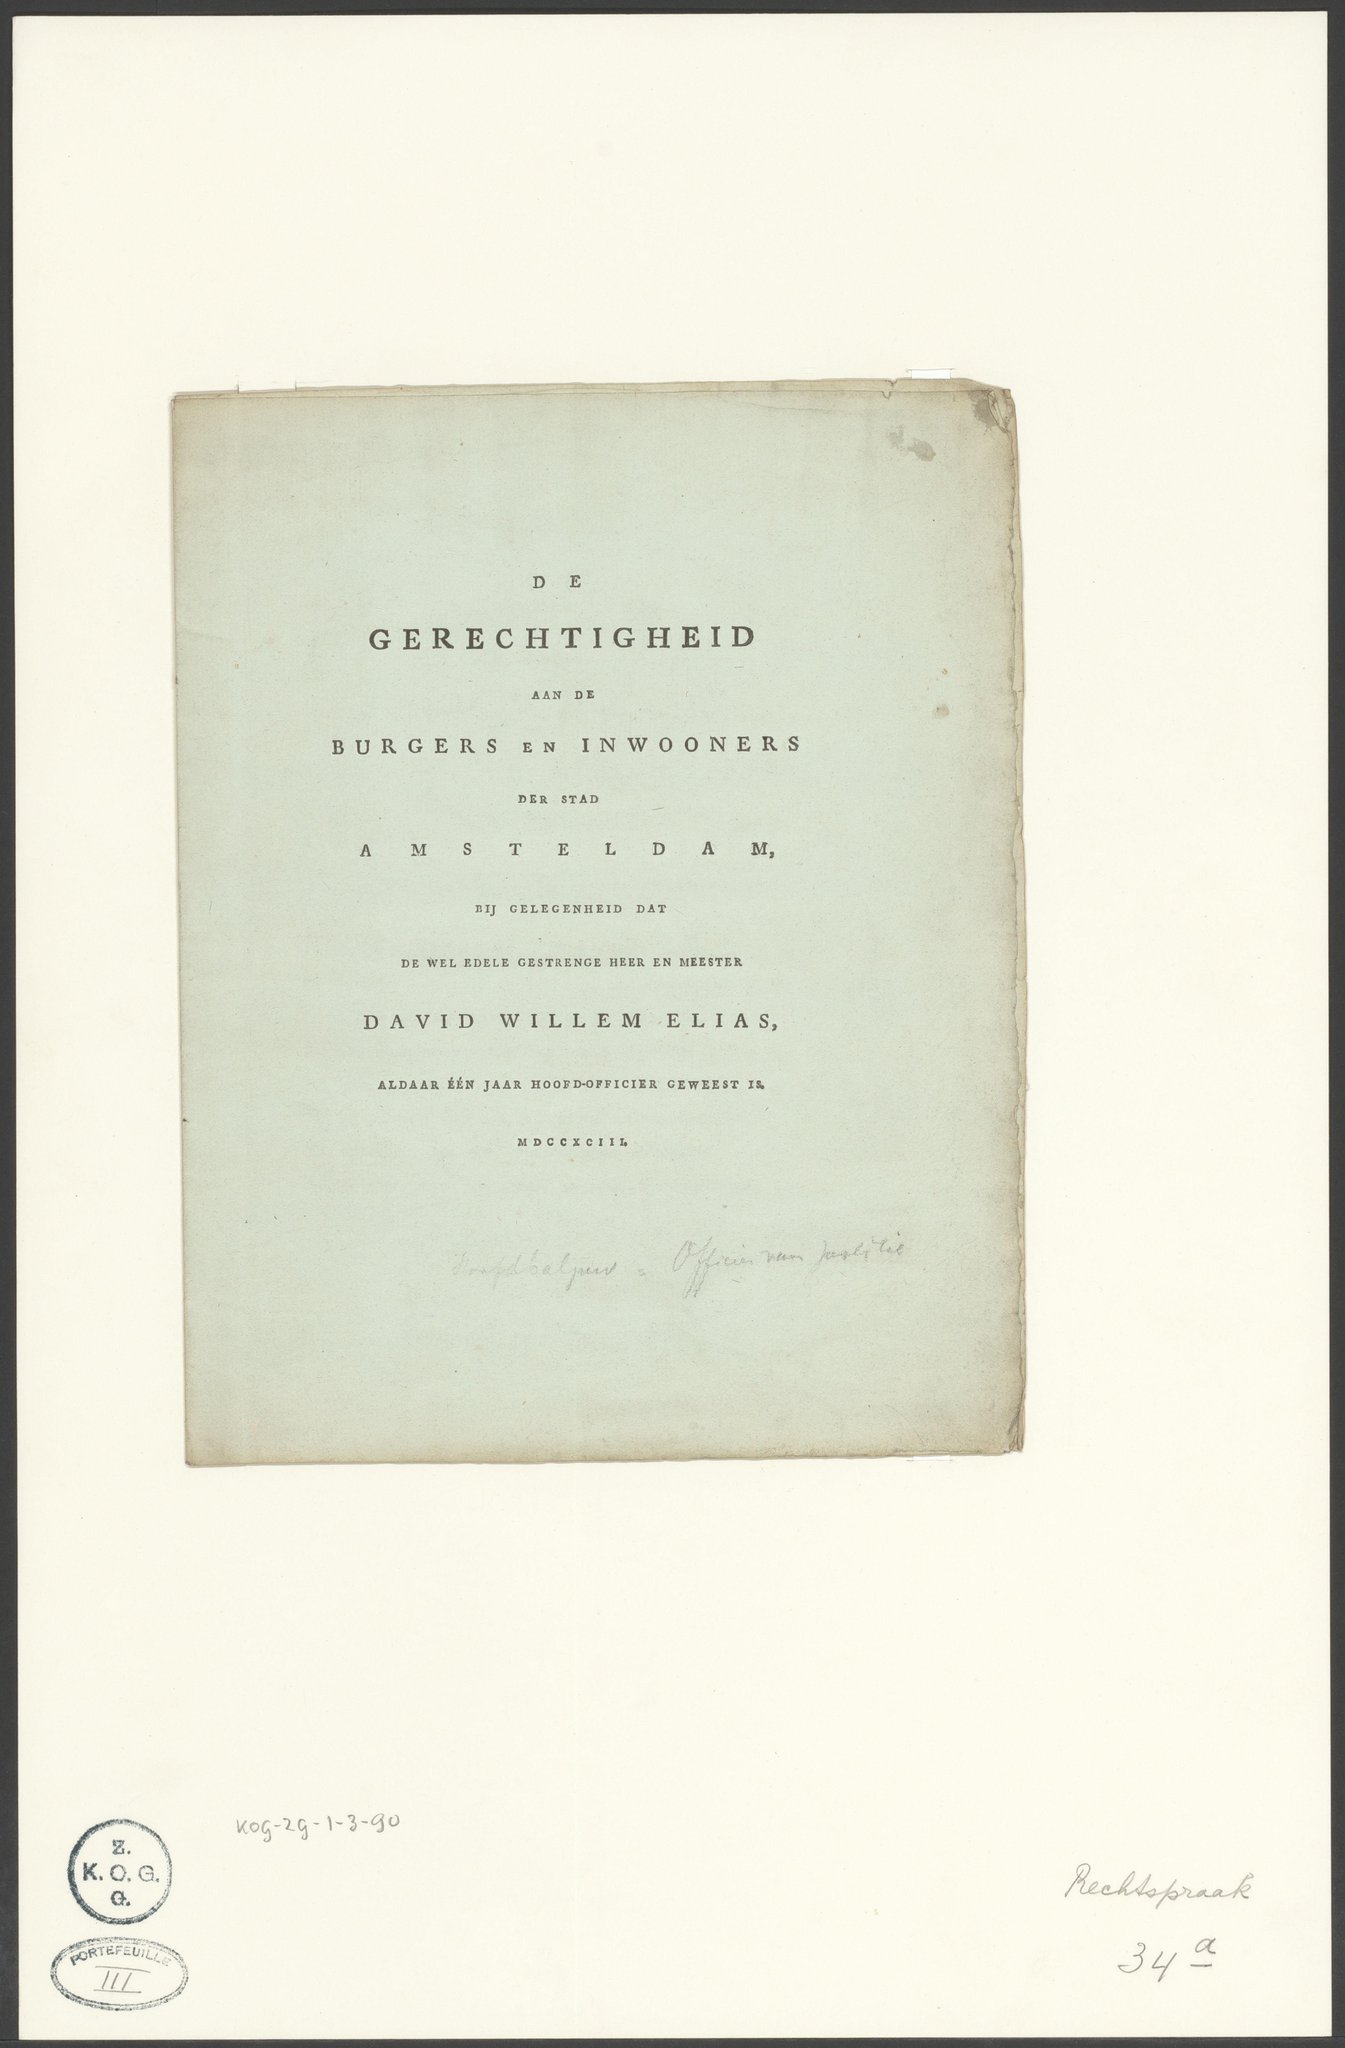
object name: text sheet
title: Lofzang op David Willem Elias die een jaar hoofdofficier van Amsterdam is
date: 1793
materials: paper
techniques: etching, letterpress printing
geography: amsterdam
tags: amsterdam, politician, mayor, justice, 'justitia'; 'giustitia divina' (ripa) ~ one of the four cardinal virtues, crowning with laurel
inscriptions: stamp, collector's mark: Lugt 1641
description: Tekstblad bestaande uit vier pagina's. De middelste twee pagina's zitten ongebonden in het object. Op de tweede pagina een prent van Vrouwe Justitia. Onderwerpsrubrieken binnen de Atlas Zeden en Gewoonten: Regeering, Rechtswezen.